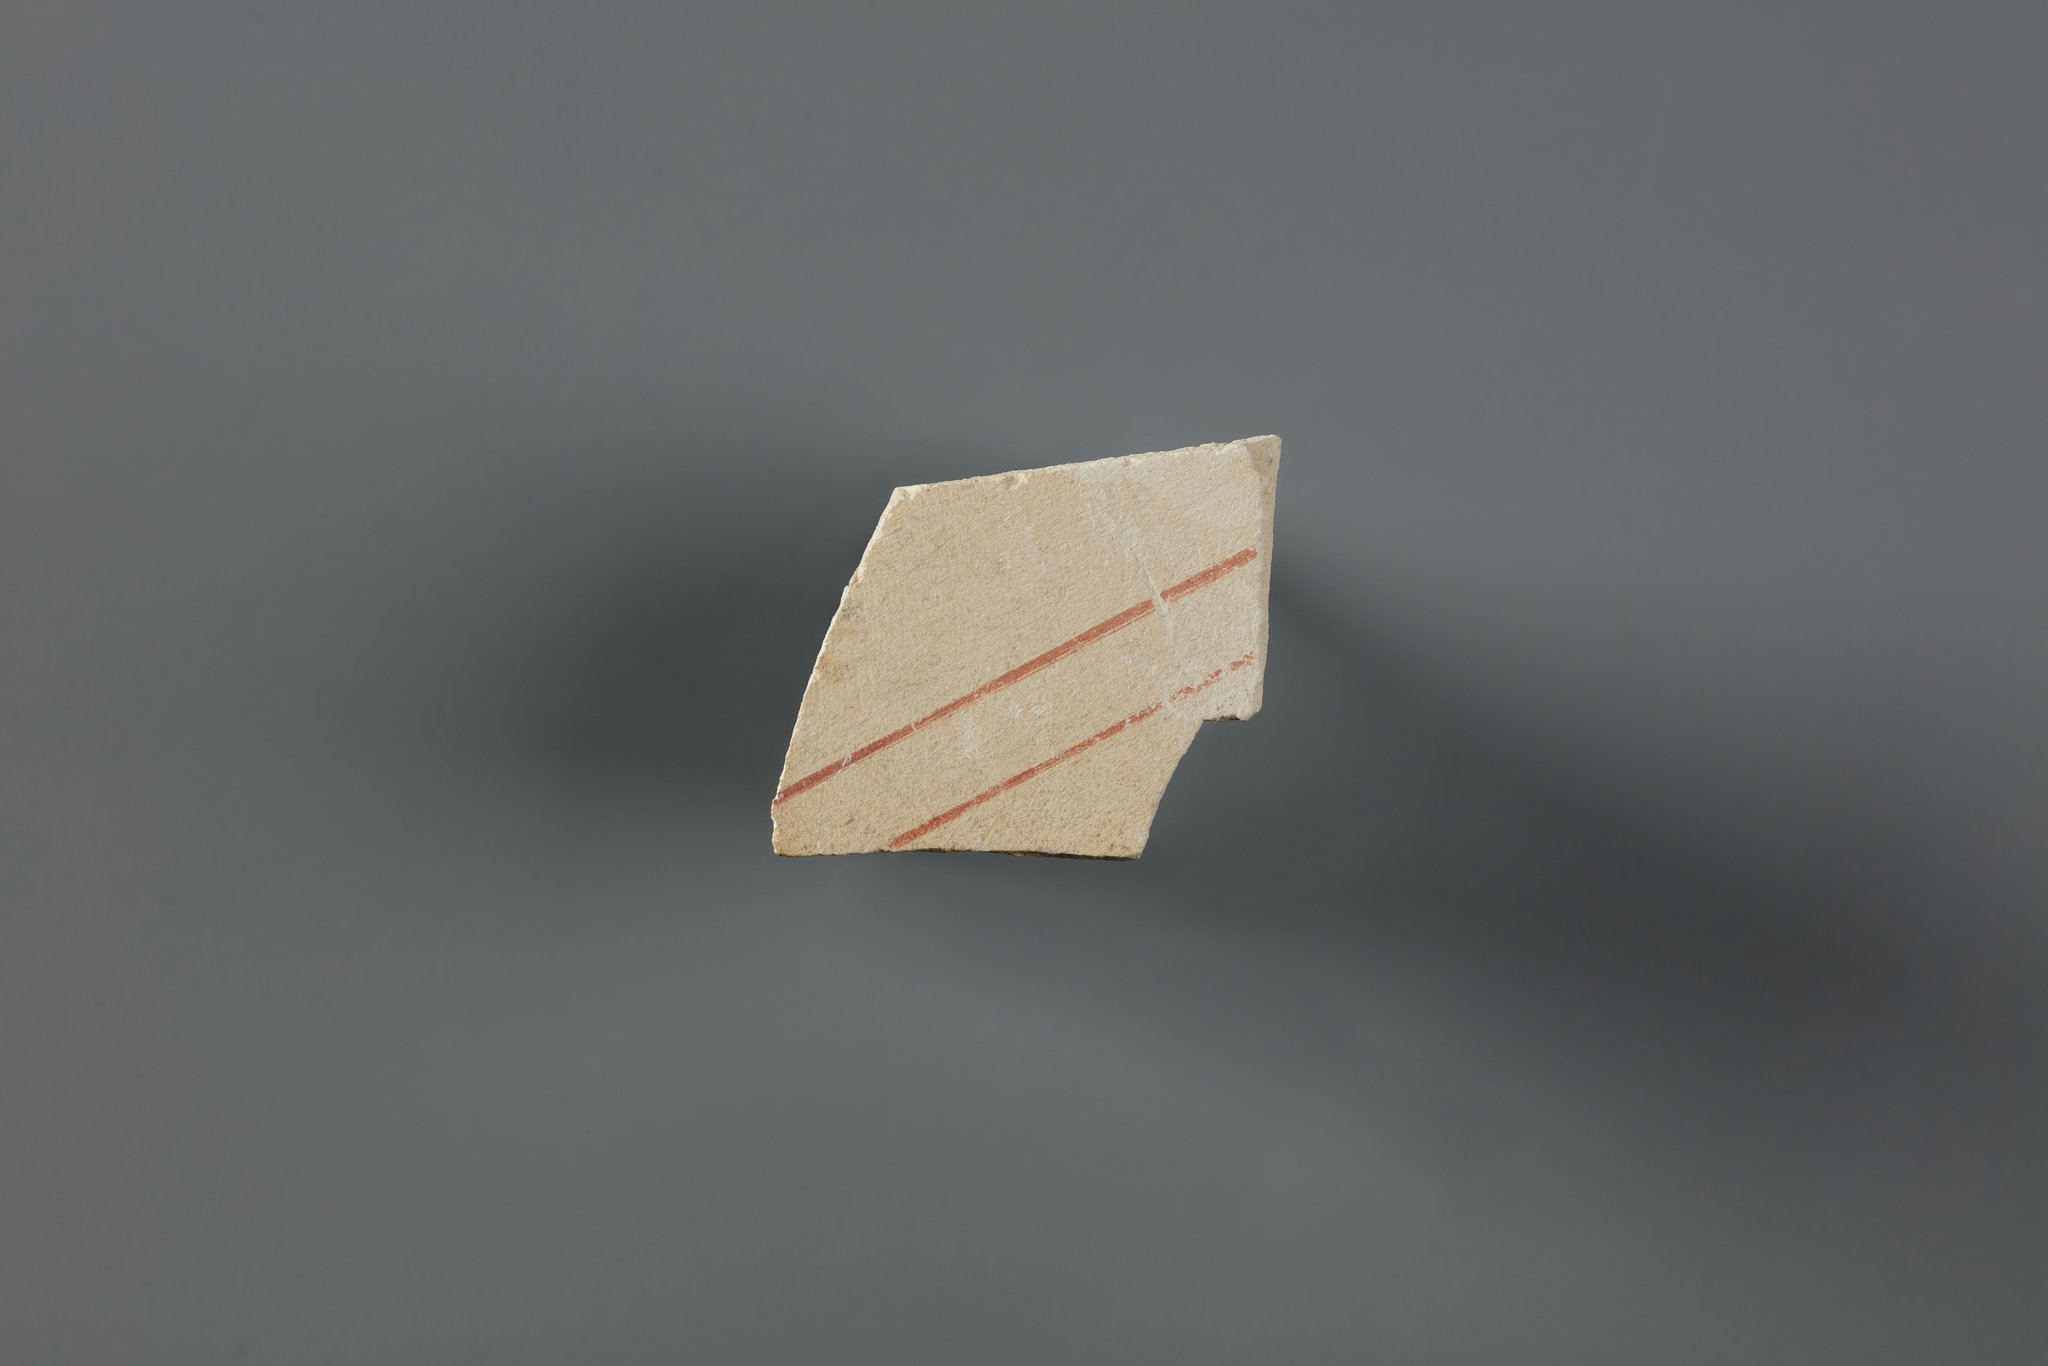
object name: relief drawing, sebeknakhte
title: Preliminary drawing for a relief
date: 2124-1504 BCE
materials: limestone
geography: egypt